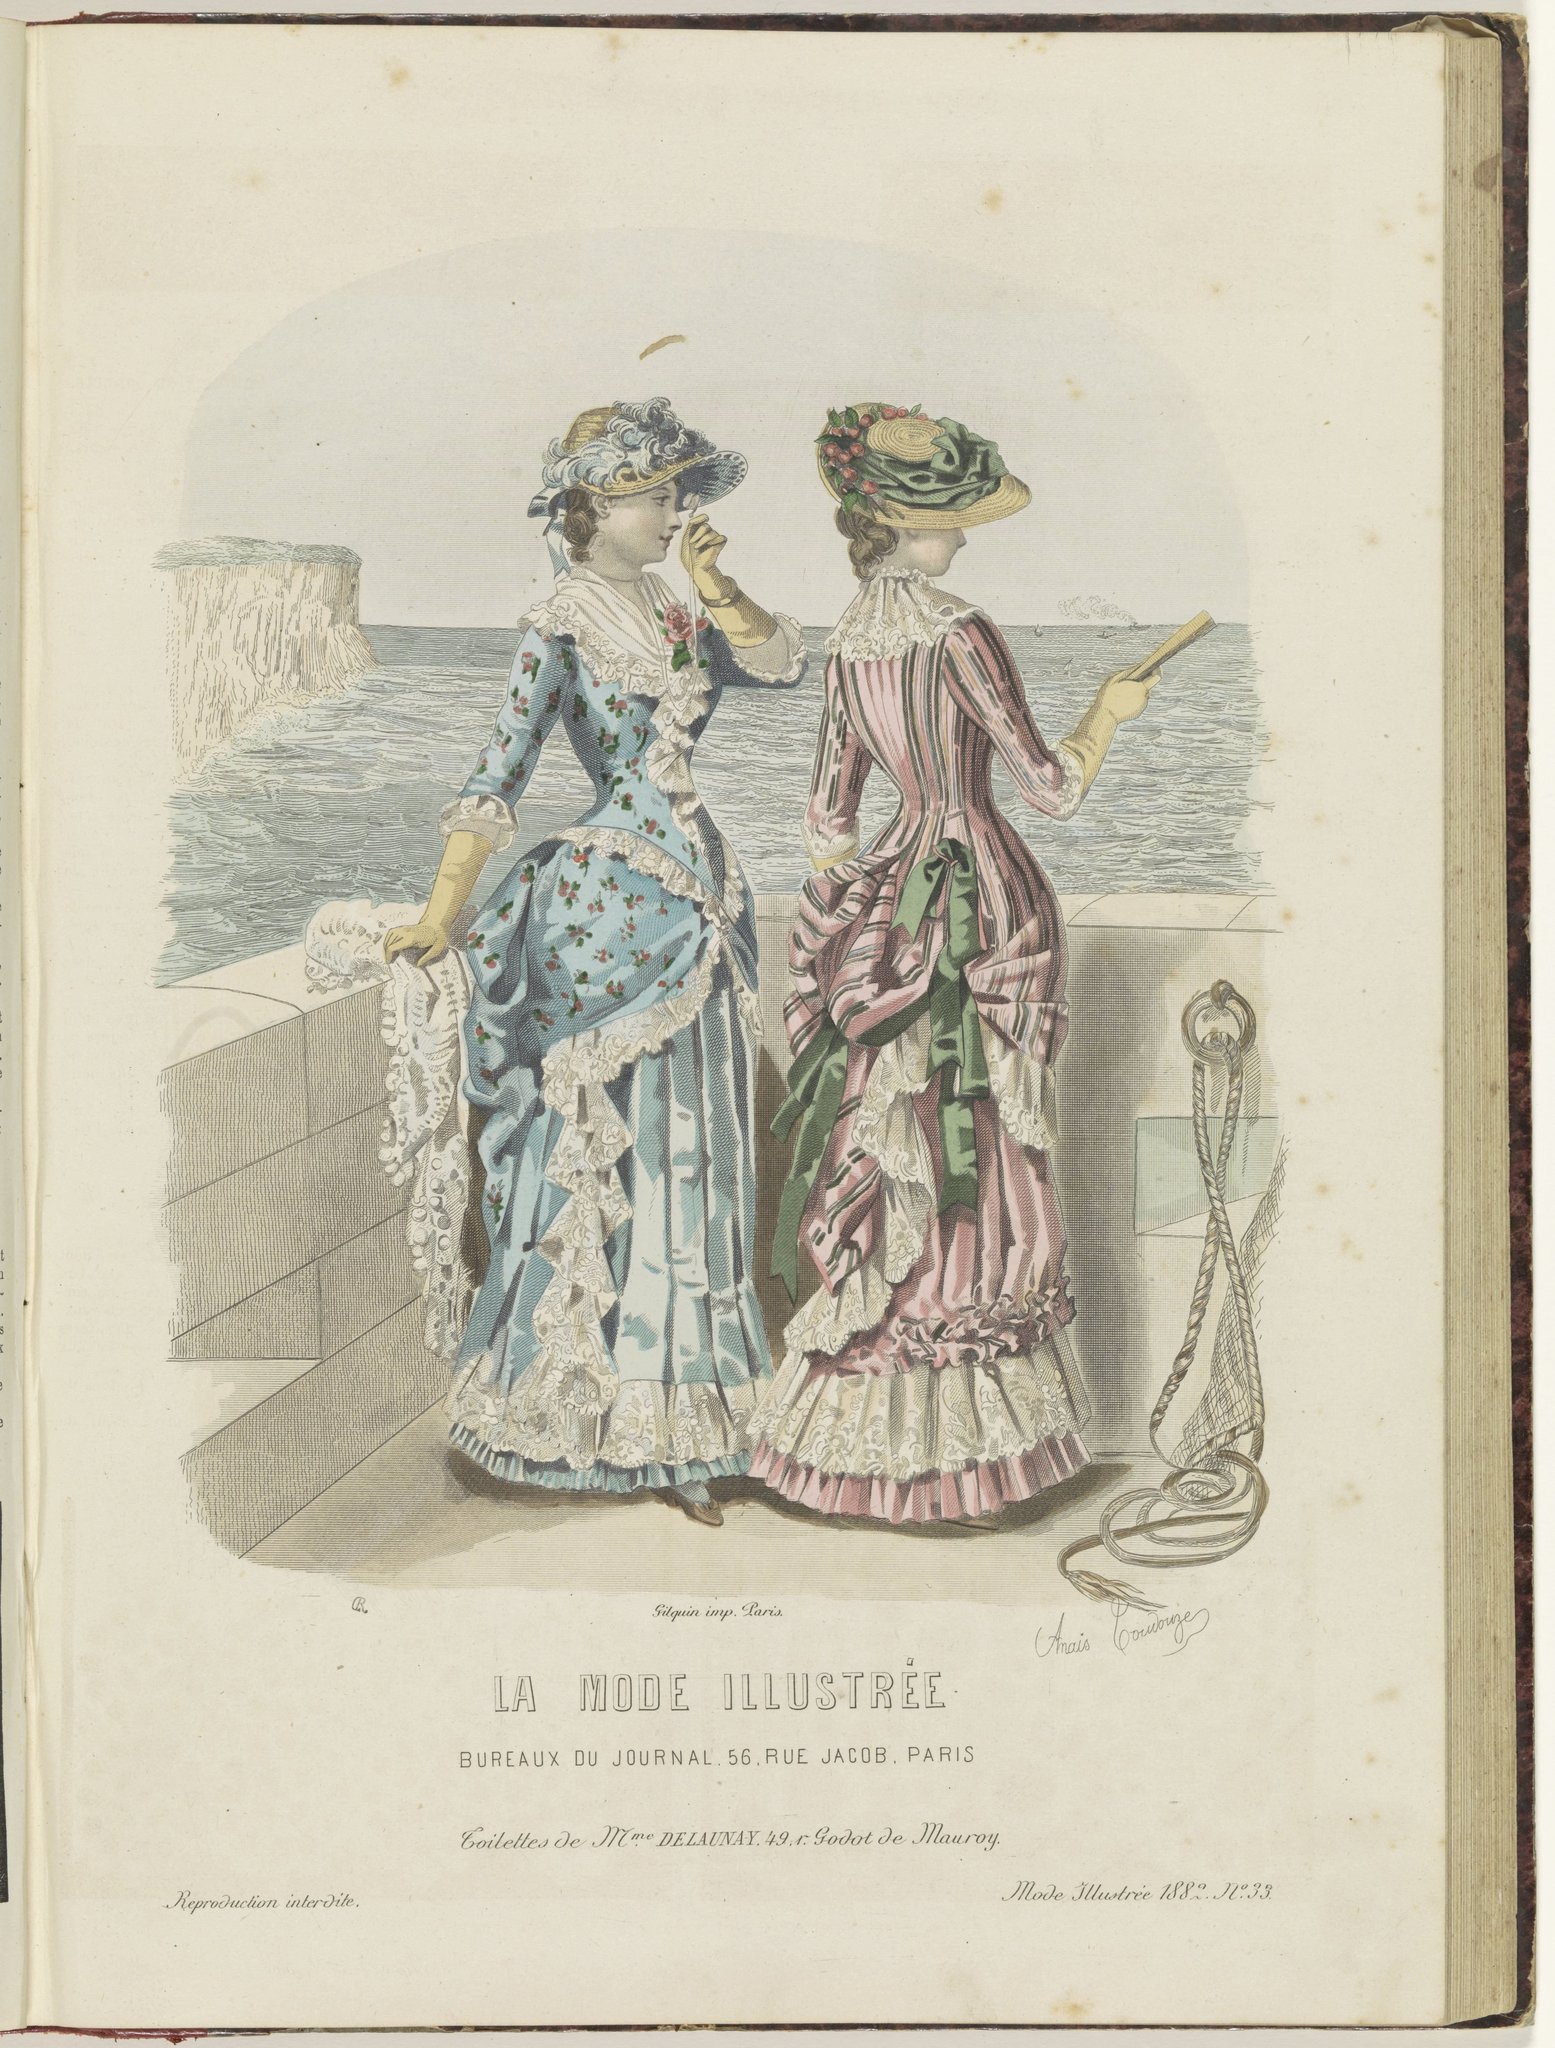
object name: magazine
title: La Mode Illustrée, Journal de la Famille, 1882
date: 1882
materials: paper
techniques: engraving, hand coloring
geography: paris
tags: fashion plates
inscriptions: date